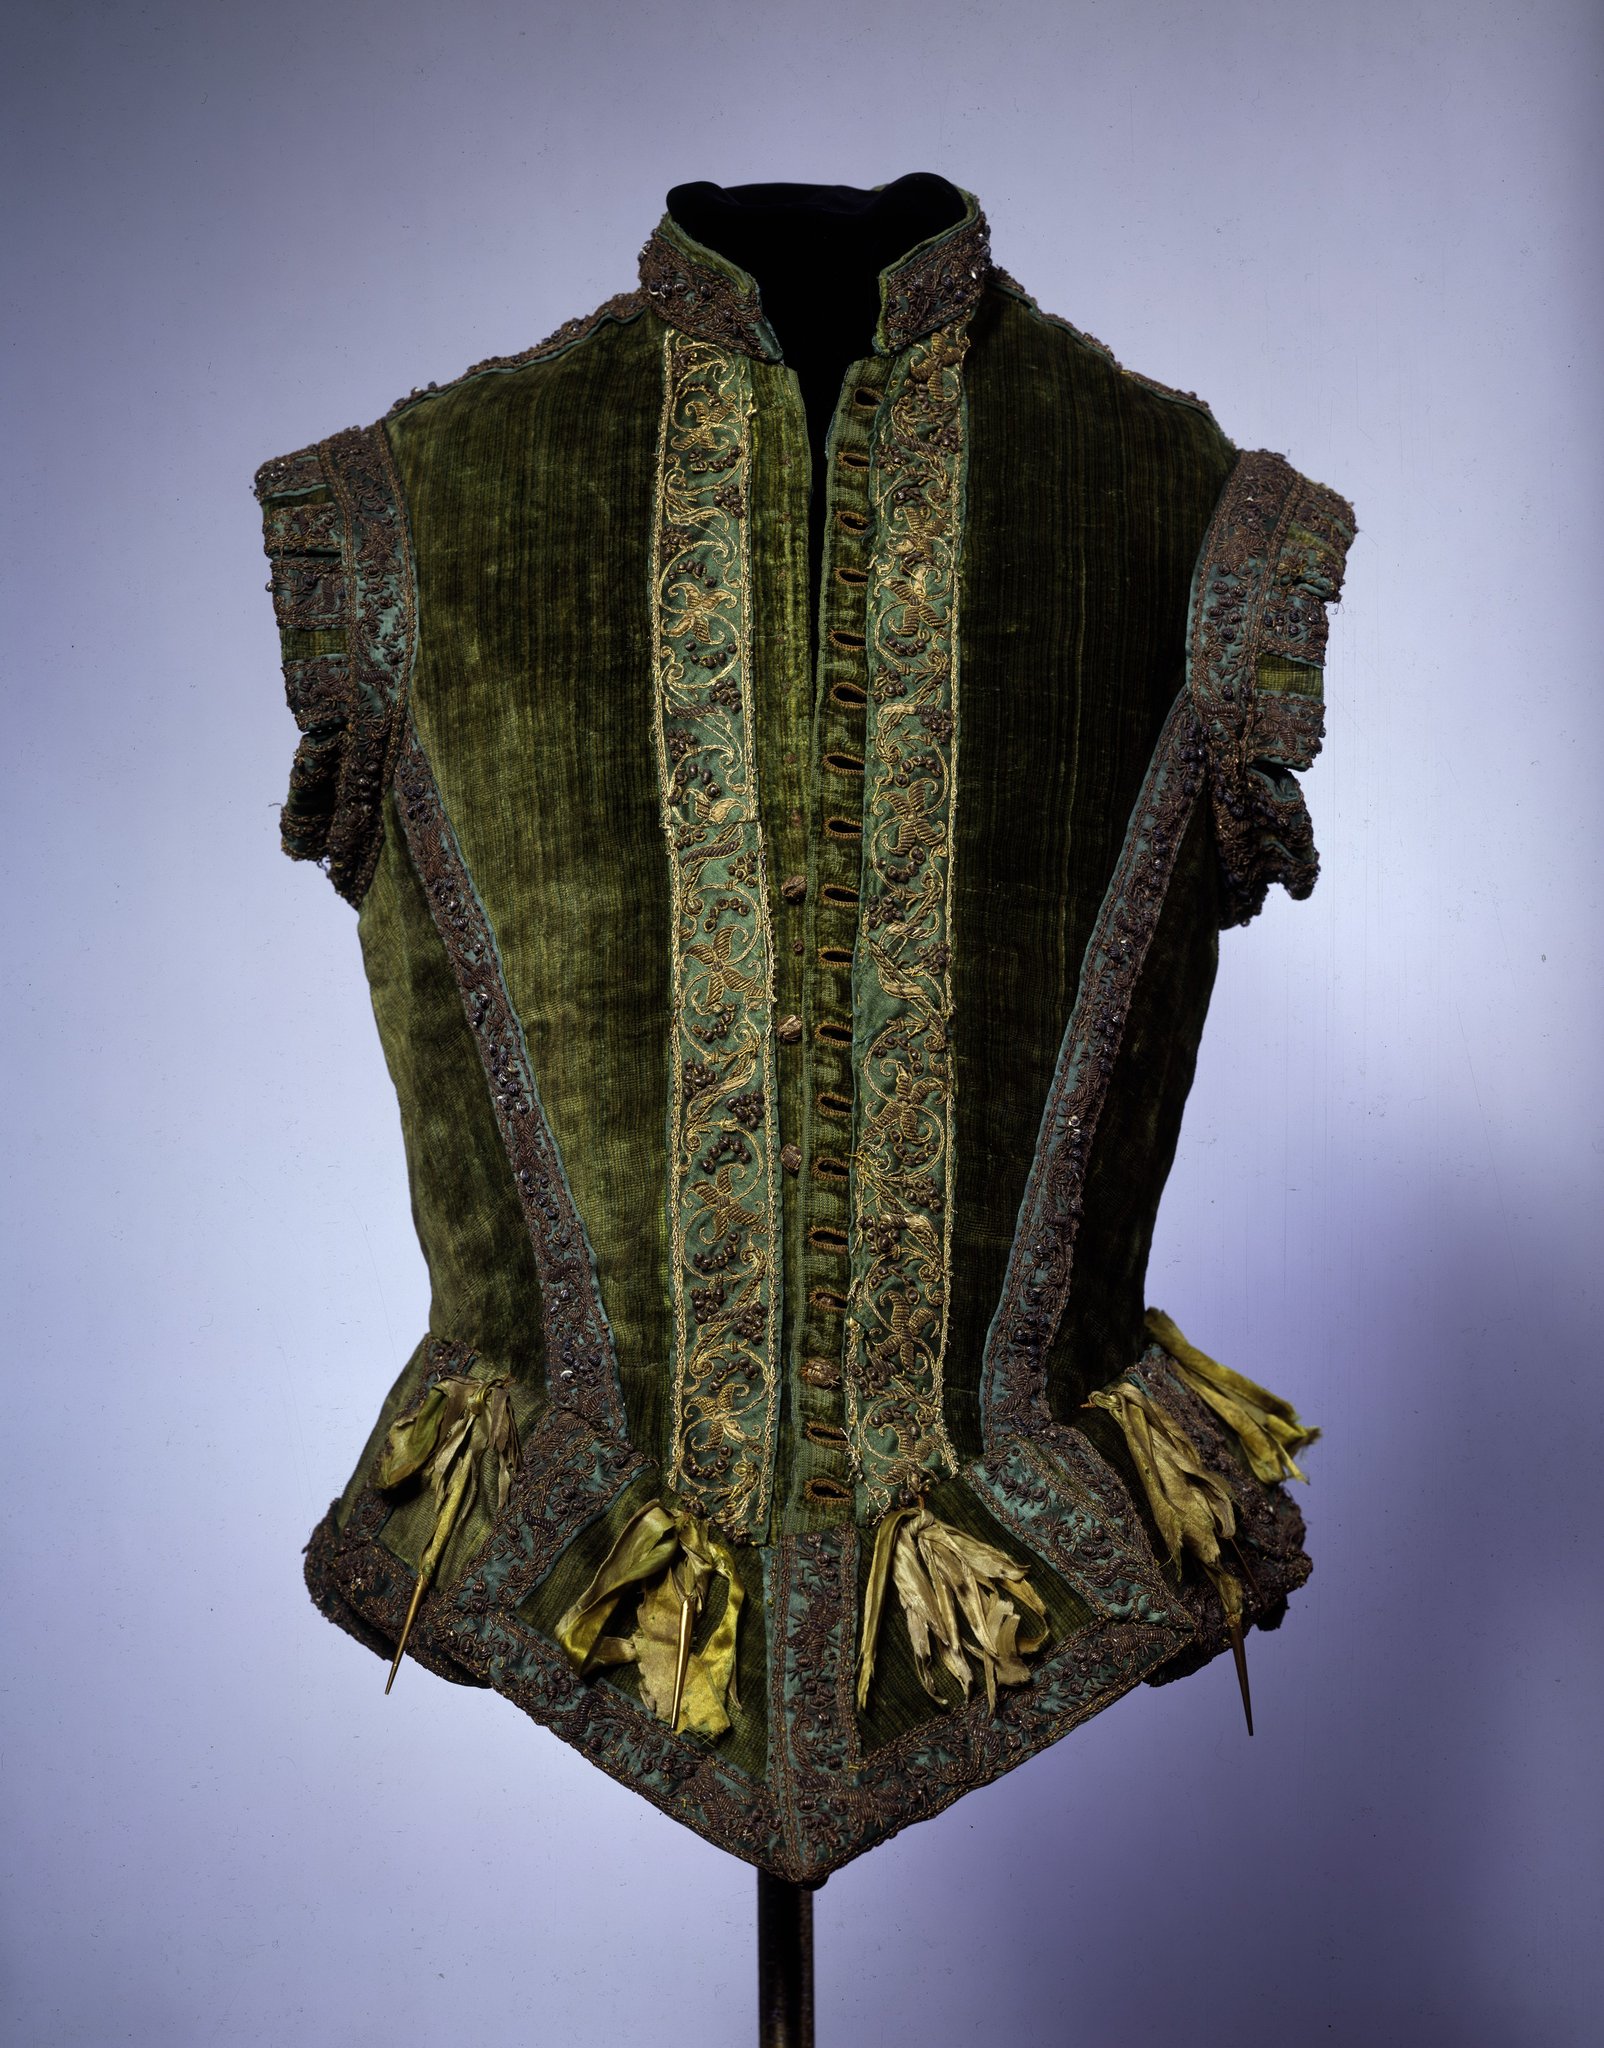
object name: doublet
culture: european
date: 1580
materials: brass, metal thread, silk